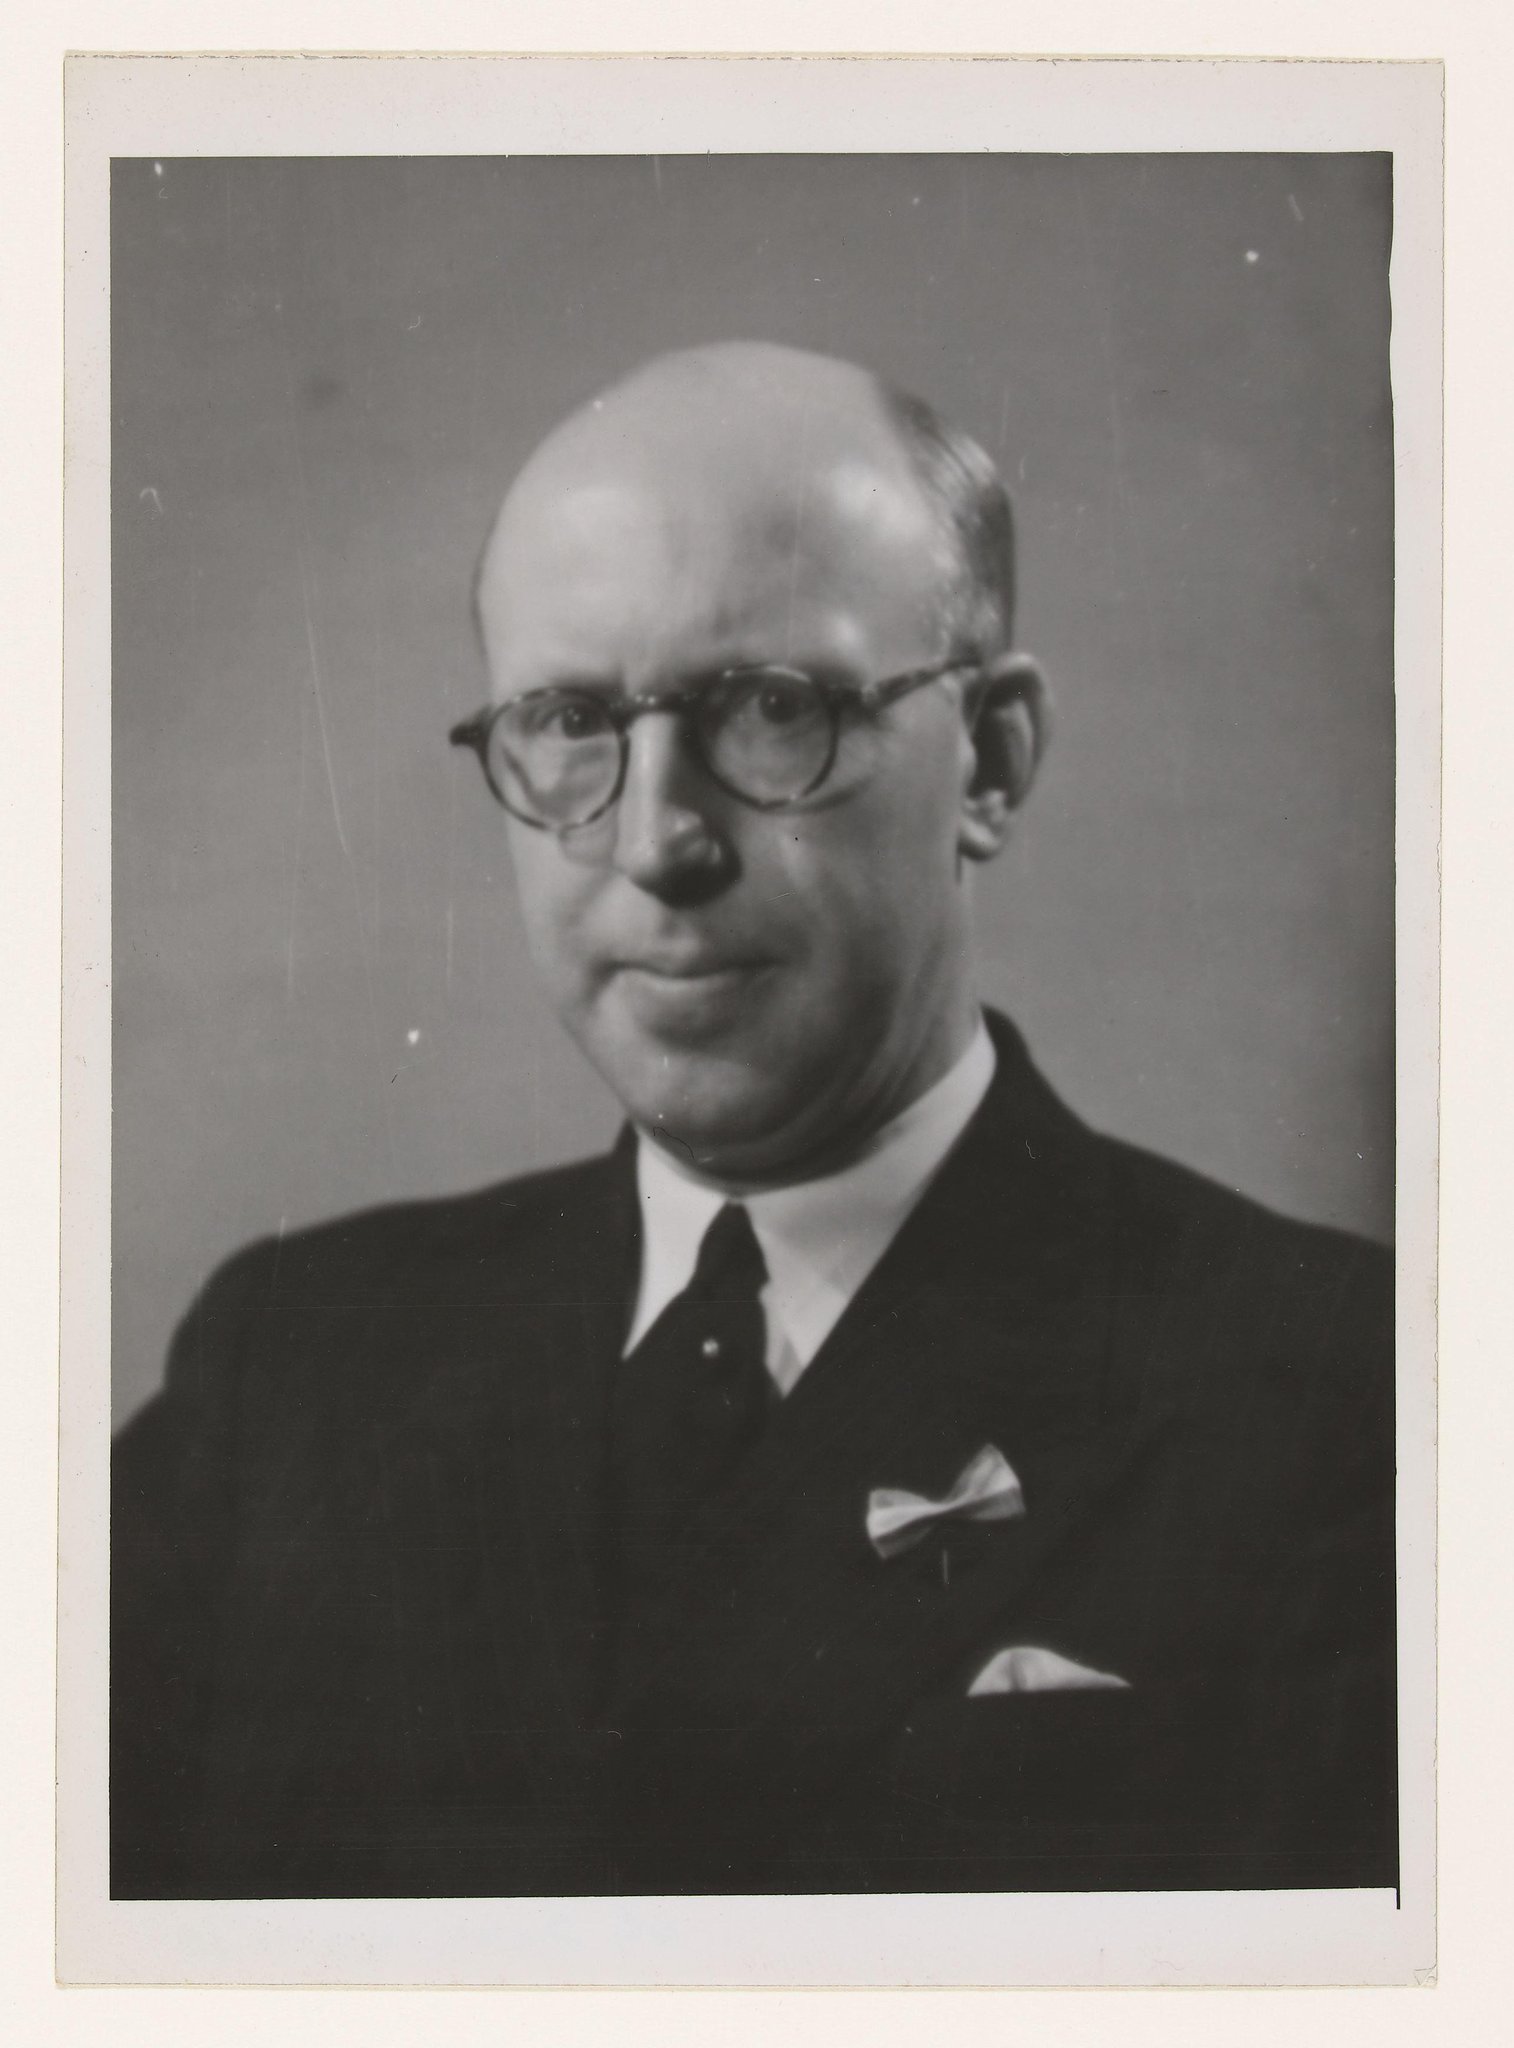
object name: documentary photograph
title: Pieter Lieftinck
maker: charles breijer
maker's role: fotograaf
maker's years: 1914-2011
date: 1946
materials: photographic support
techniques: photography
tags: muiderberg, tweede kamerlid, directeur, hoogleraar, minister van financiën, secretaris, eerste kamerlid, pieter lieftinck, ons vrije nederland, tweede wereldoorlog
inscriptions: number: ‘14788’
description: Portretfoto Piet Lieftinck met bril en decoratie op zijn revers.